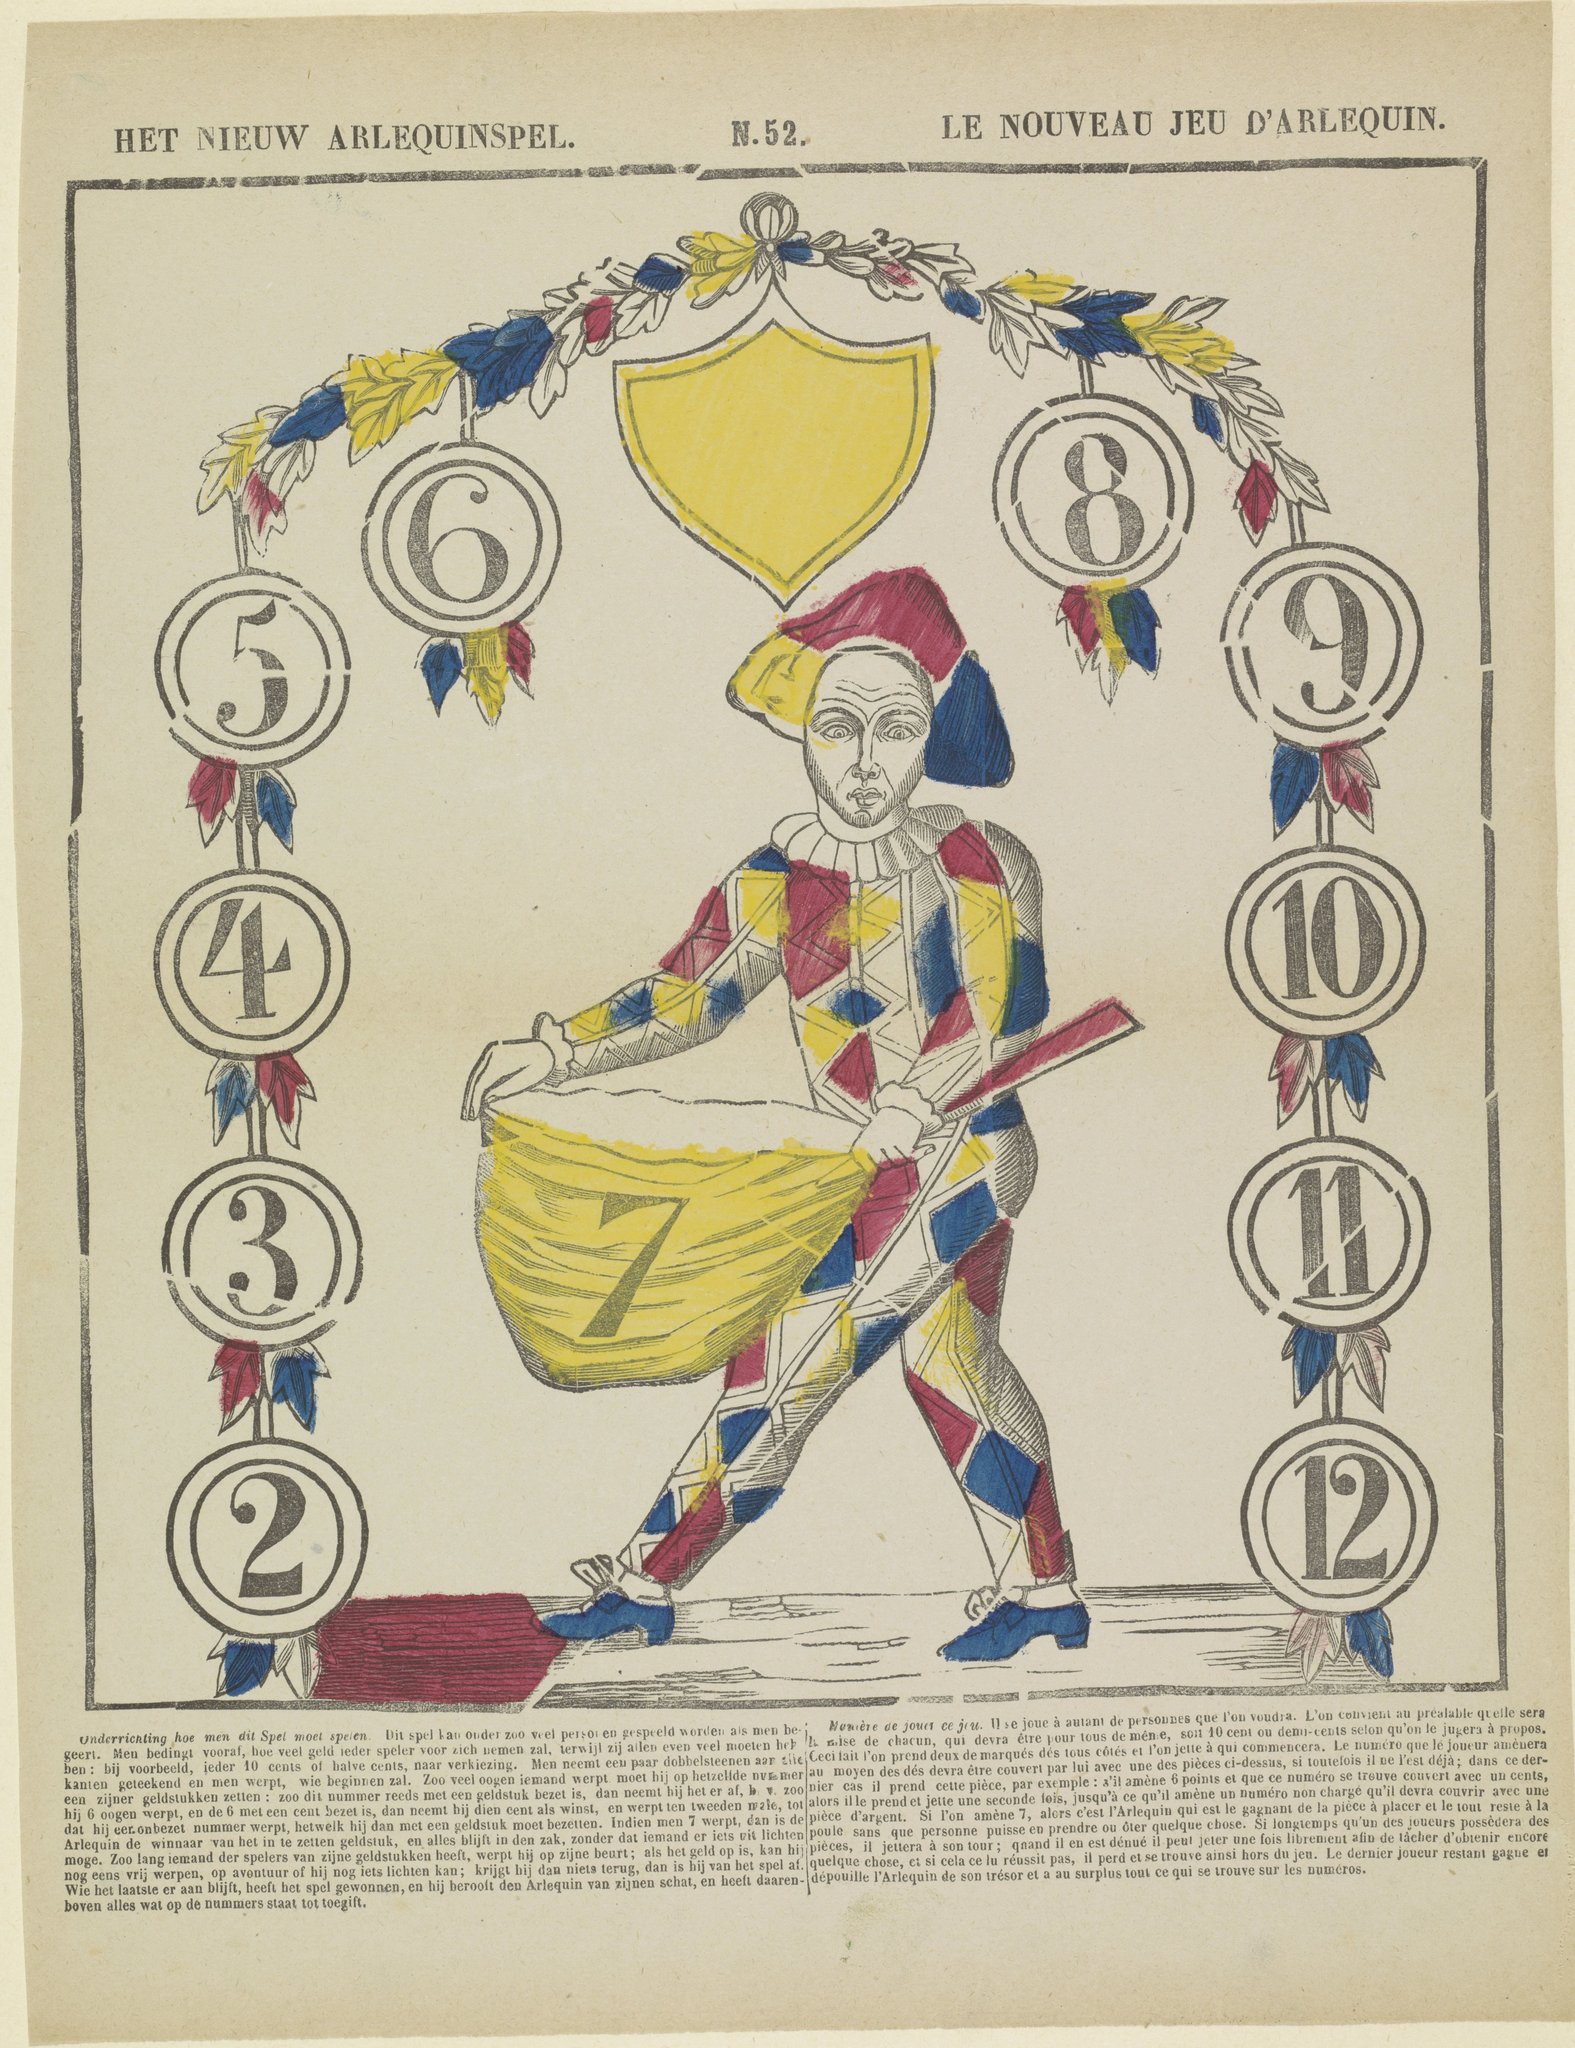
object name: popular print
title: Het nieuw arlequinspel / Le nouveau jeu d'arlequin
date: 1800-1833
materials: paper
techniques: colour, letterpress printing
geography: turnhout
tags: board-games of chance, types in 'commedia dell'arte': harlequin, board-games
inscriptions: collector's mark: Lugt 2760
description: Bordspel met in het midden van het speelveld een harlekijn die in zijn geopende handen een zak houdt met daarop het cijfer 7. Rondom hem een guirlande waaraan medaillons hangen met de cijfers 2 tot en met 12. Bovenaan in het midden een schild. Onder de voorstelling de spelregels in het Nederlands en in het Frans in twee kolommen. Genummerd midden boven: N. 52.